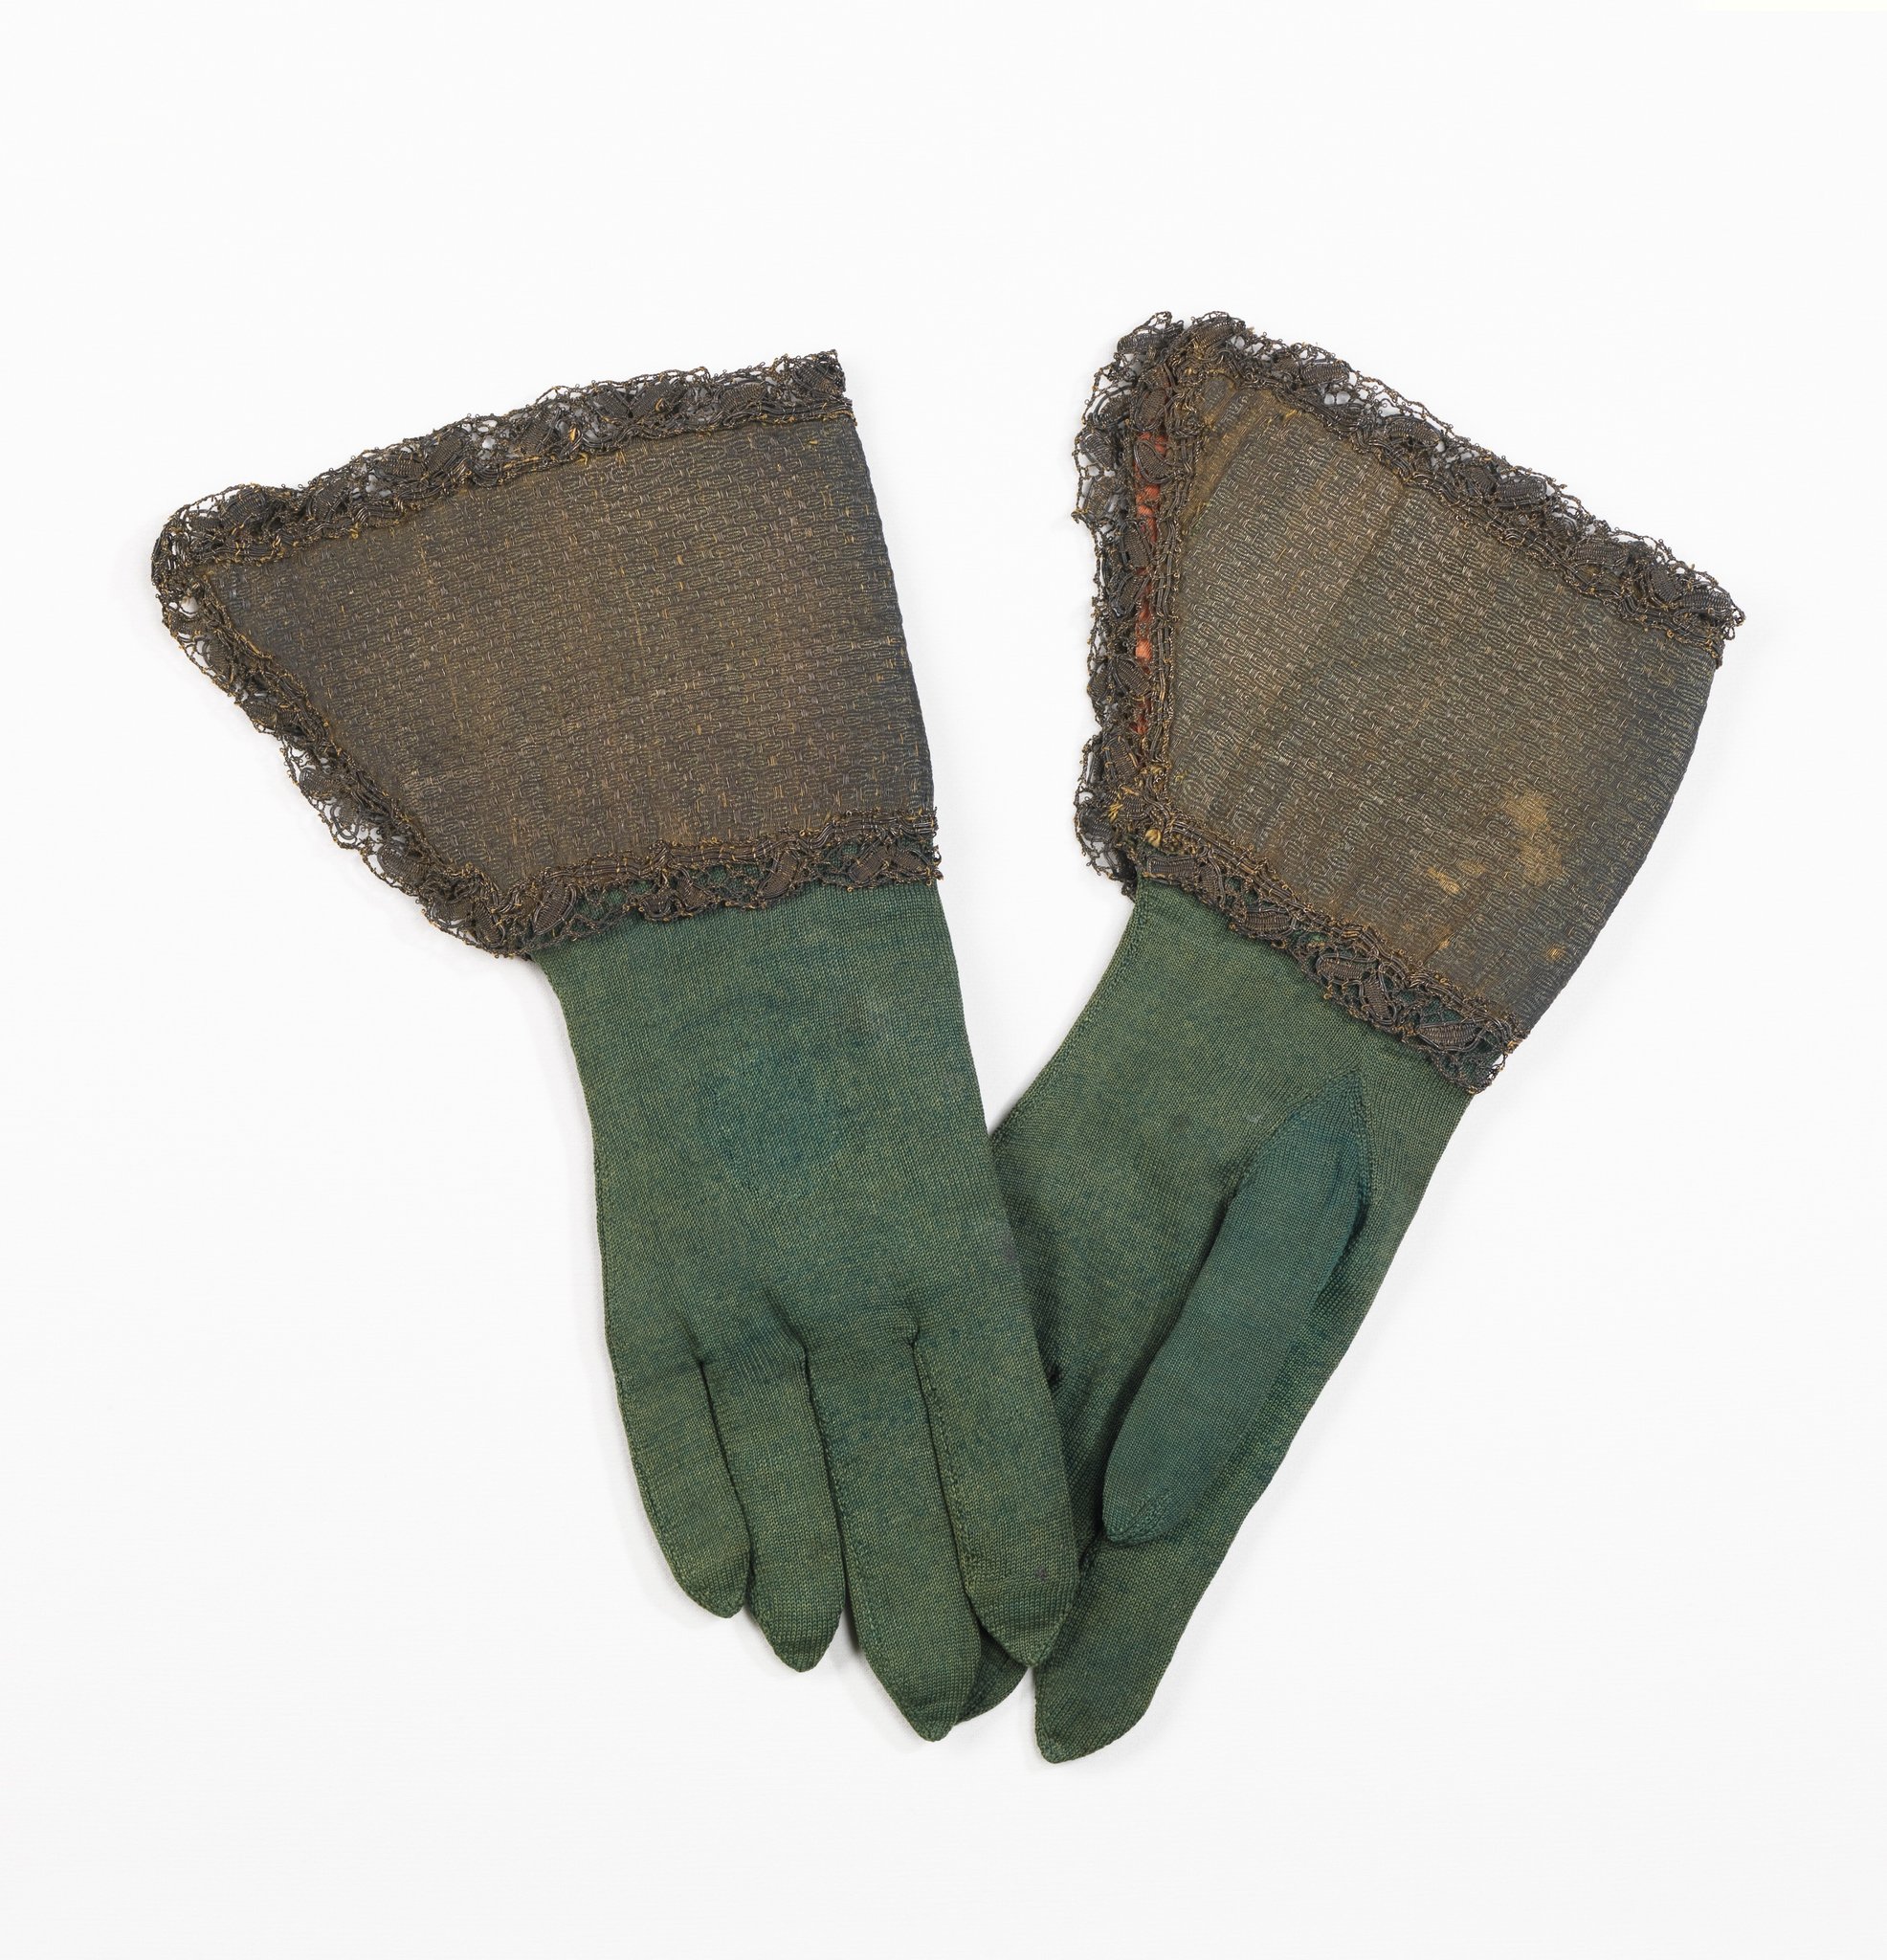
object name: gauntlet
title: Gauntlets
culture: russian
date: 1701-1725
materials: metal, silk